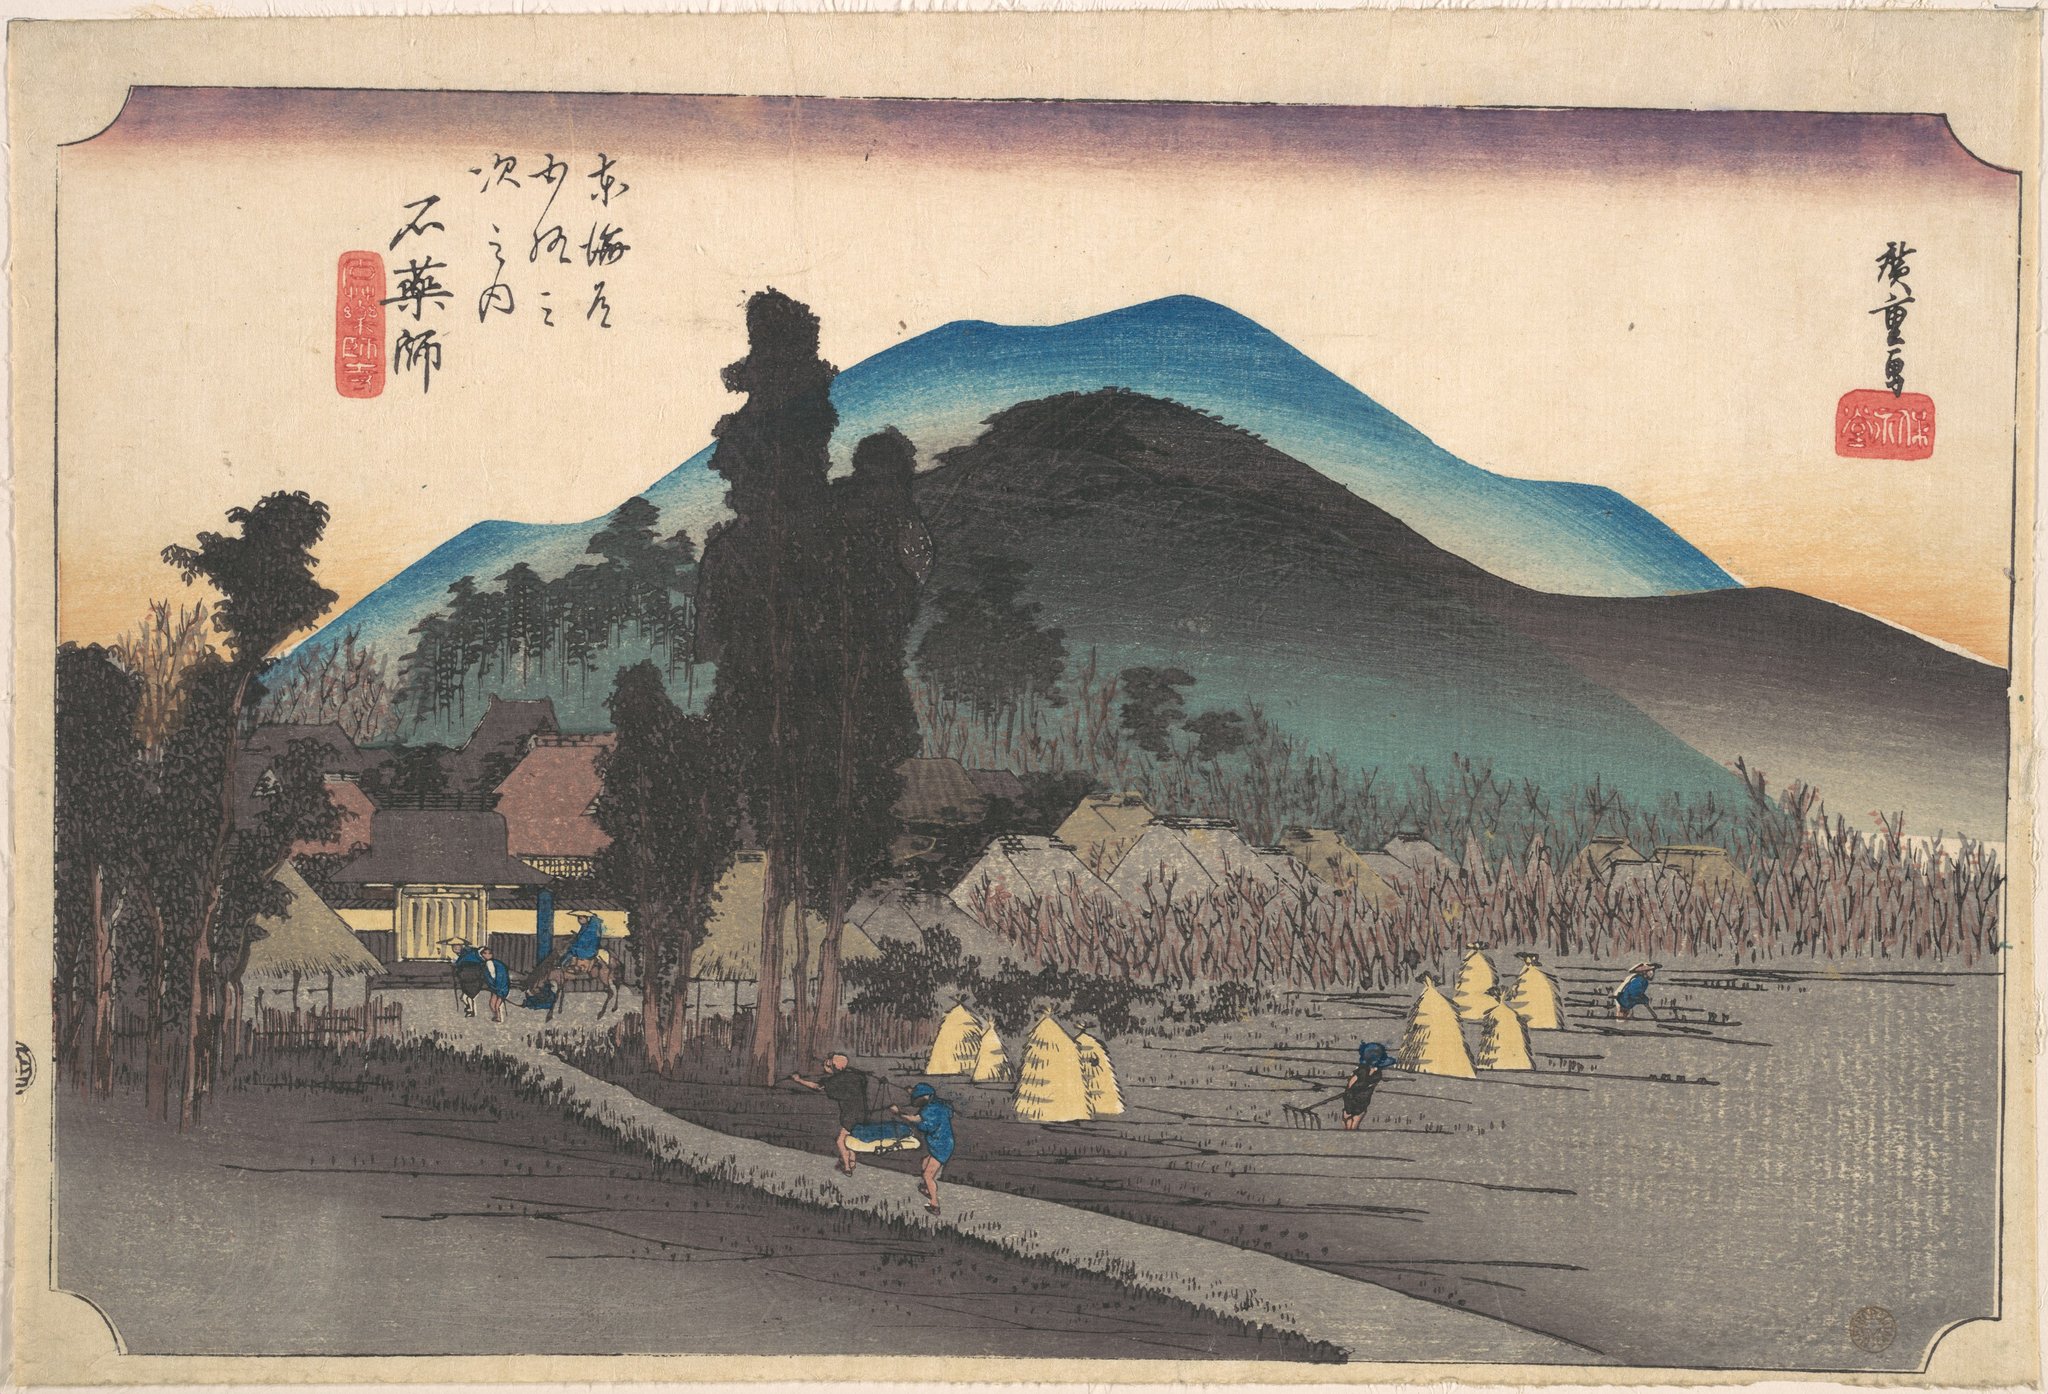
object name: print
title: Ishiyakushi, Ishiyakushi Ji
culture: japanese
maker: utagawa hiroshige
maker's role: artist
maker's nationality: japanese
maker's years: 1797-1858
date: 1834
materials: ink, paper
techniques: woodblock print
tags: human figures,houses,mountains,trees